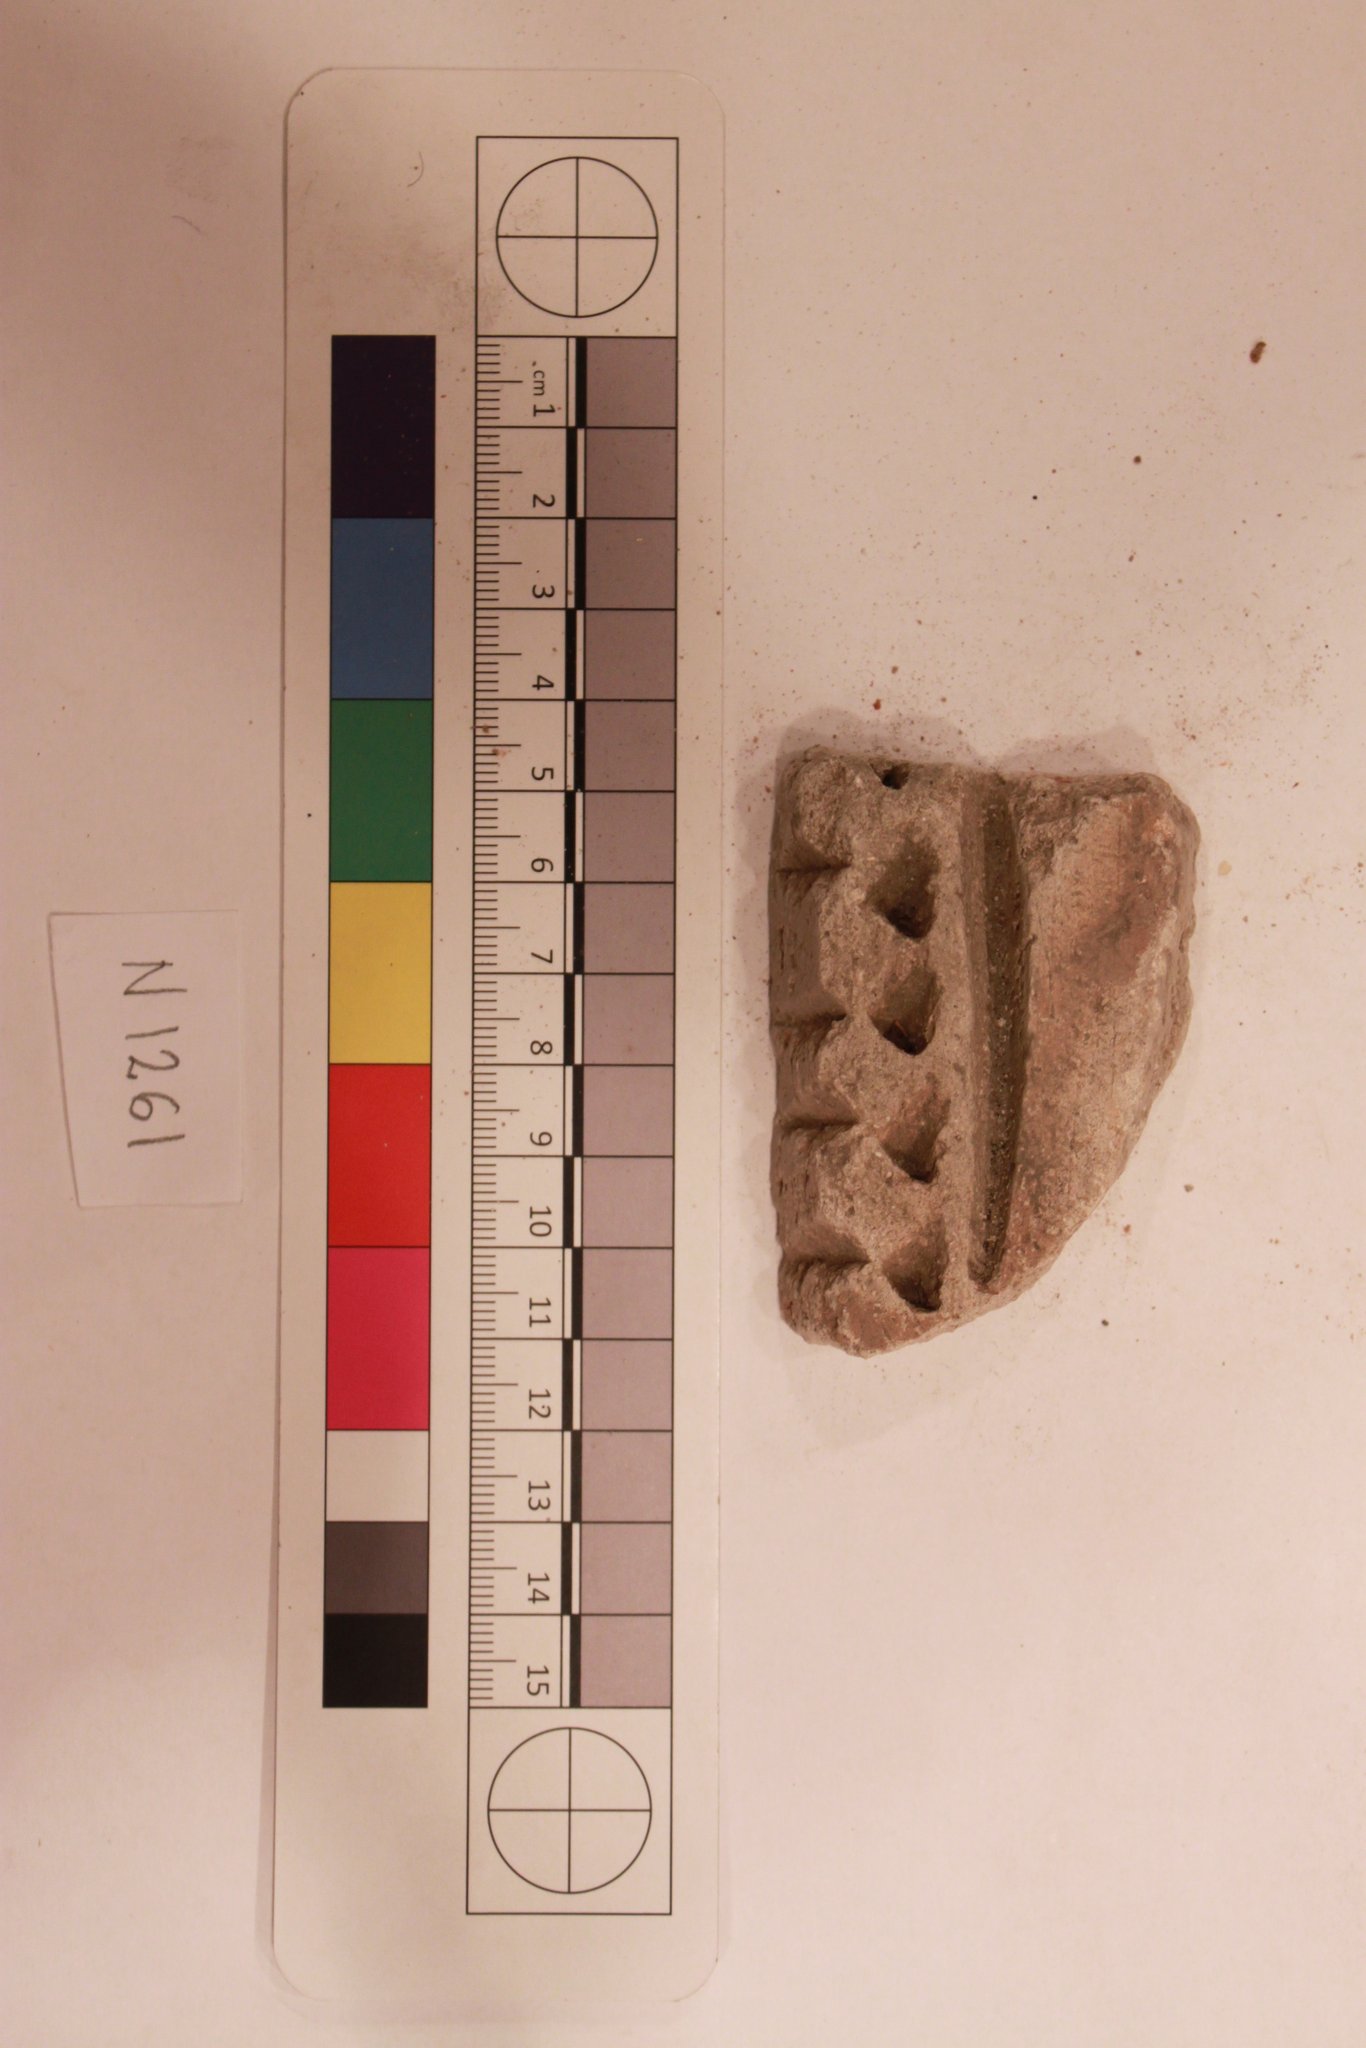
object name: fragment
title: Stucco Fragment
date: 701-1200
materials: plaster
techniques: carving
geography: iran